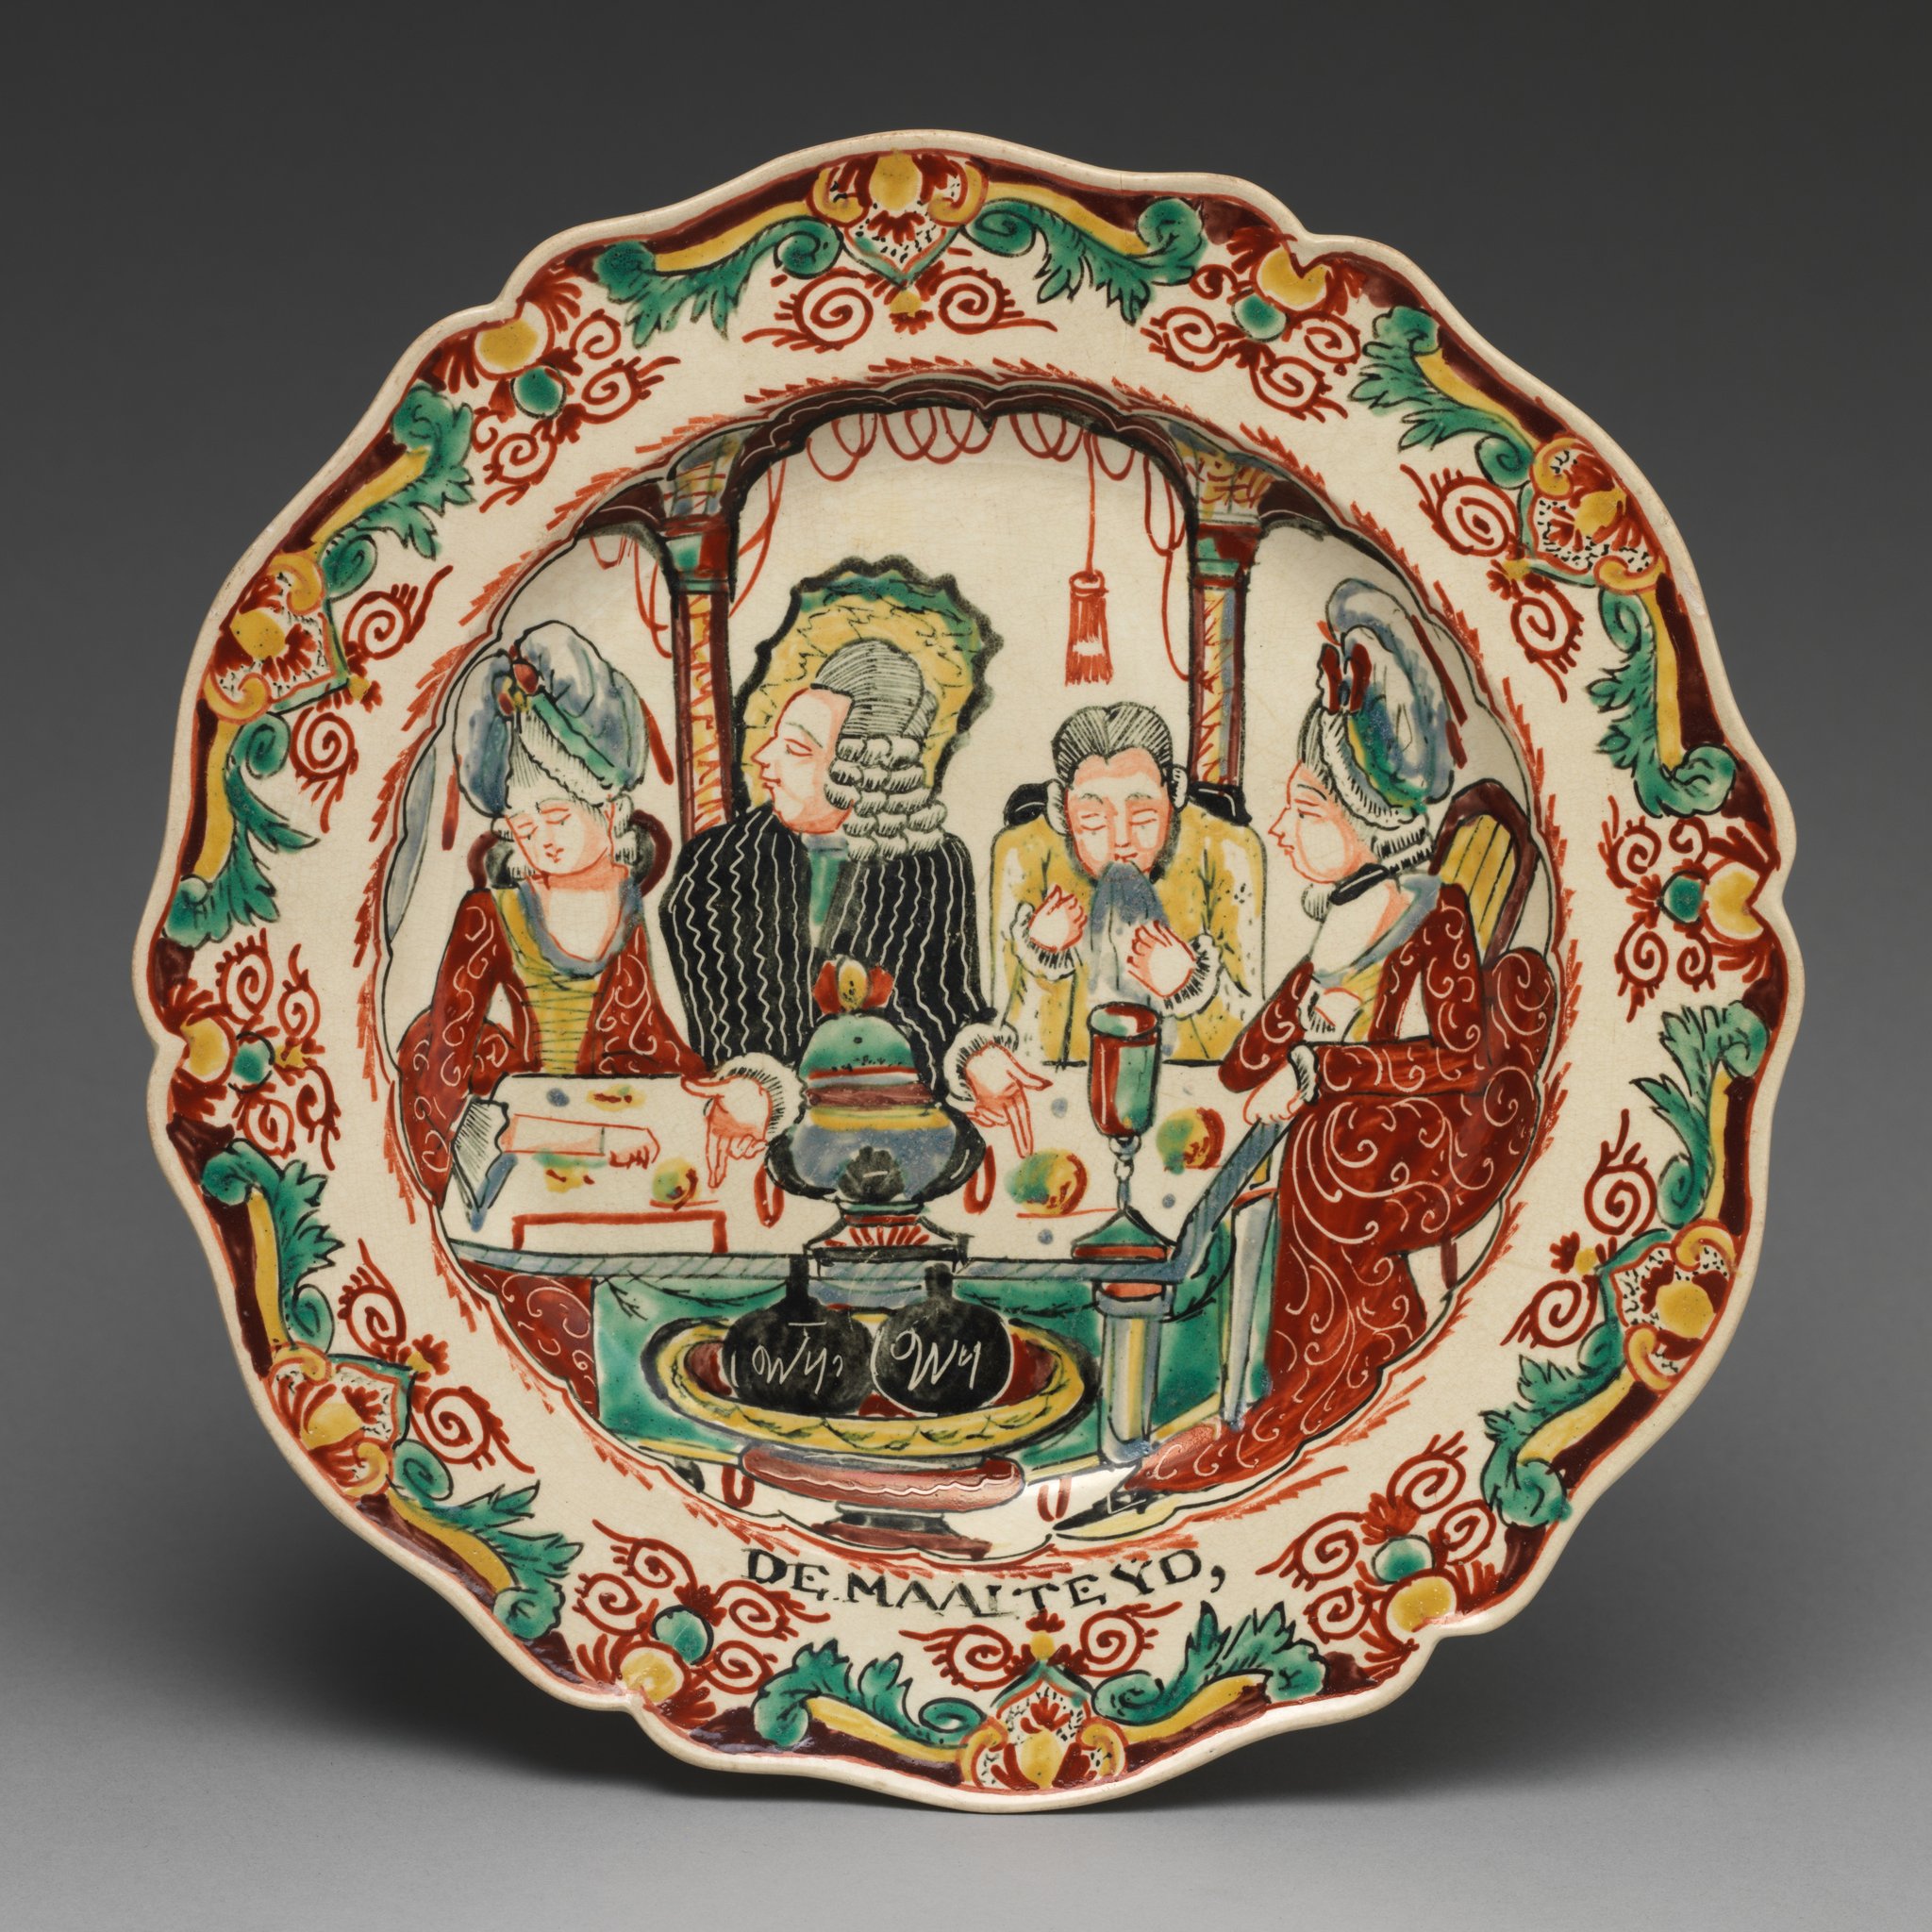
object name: plate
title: Plate (part of a set of six)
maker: john turner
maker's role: maker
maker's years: 1762-1786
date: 1790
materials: earthenware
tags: men,women,dining